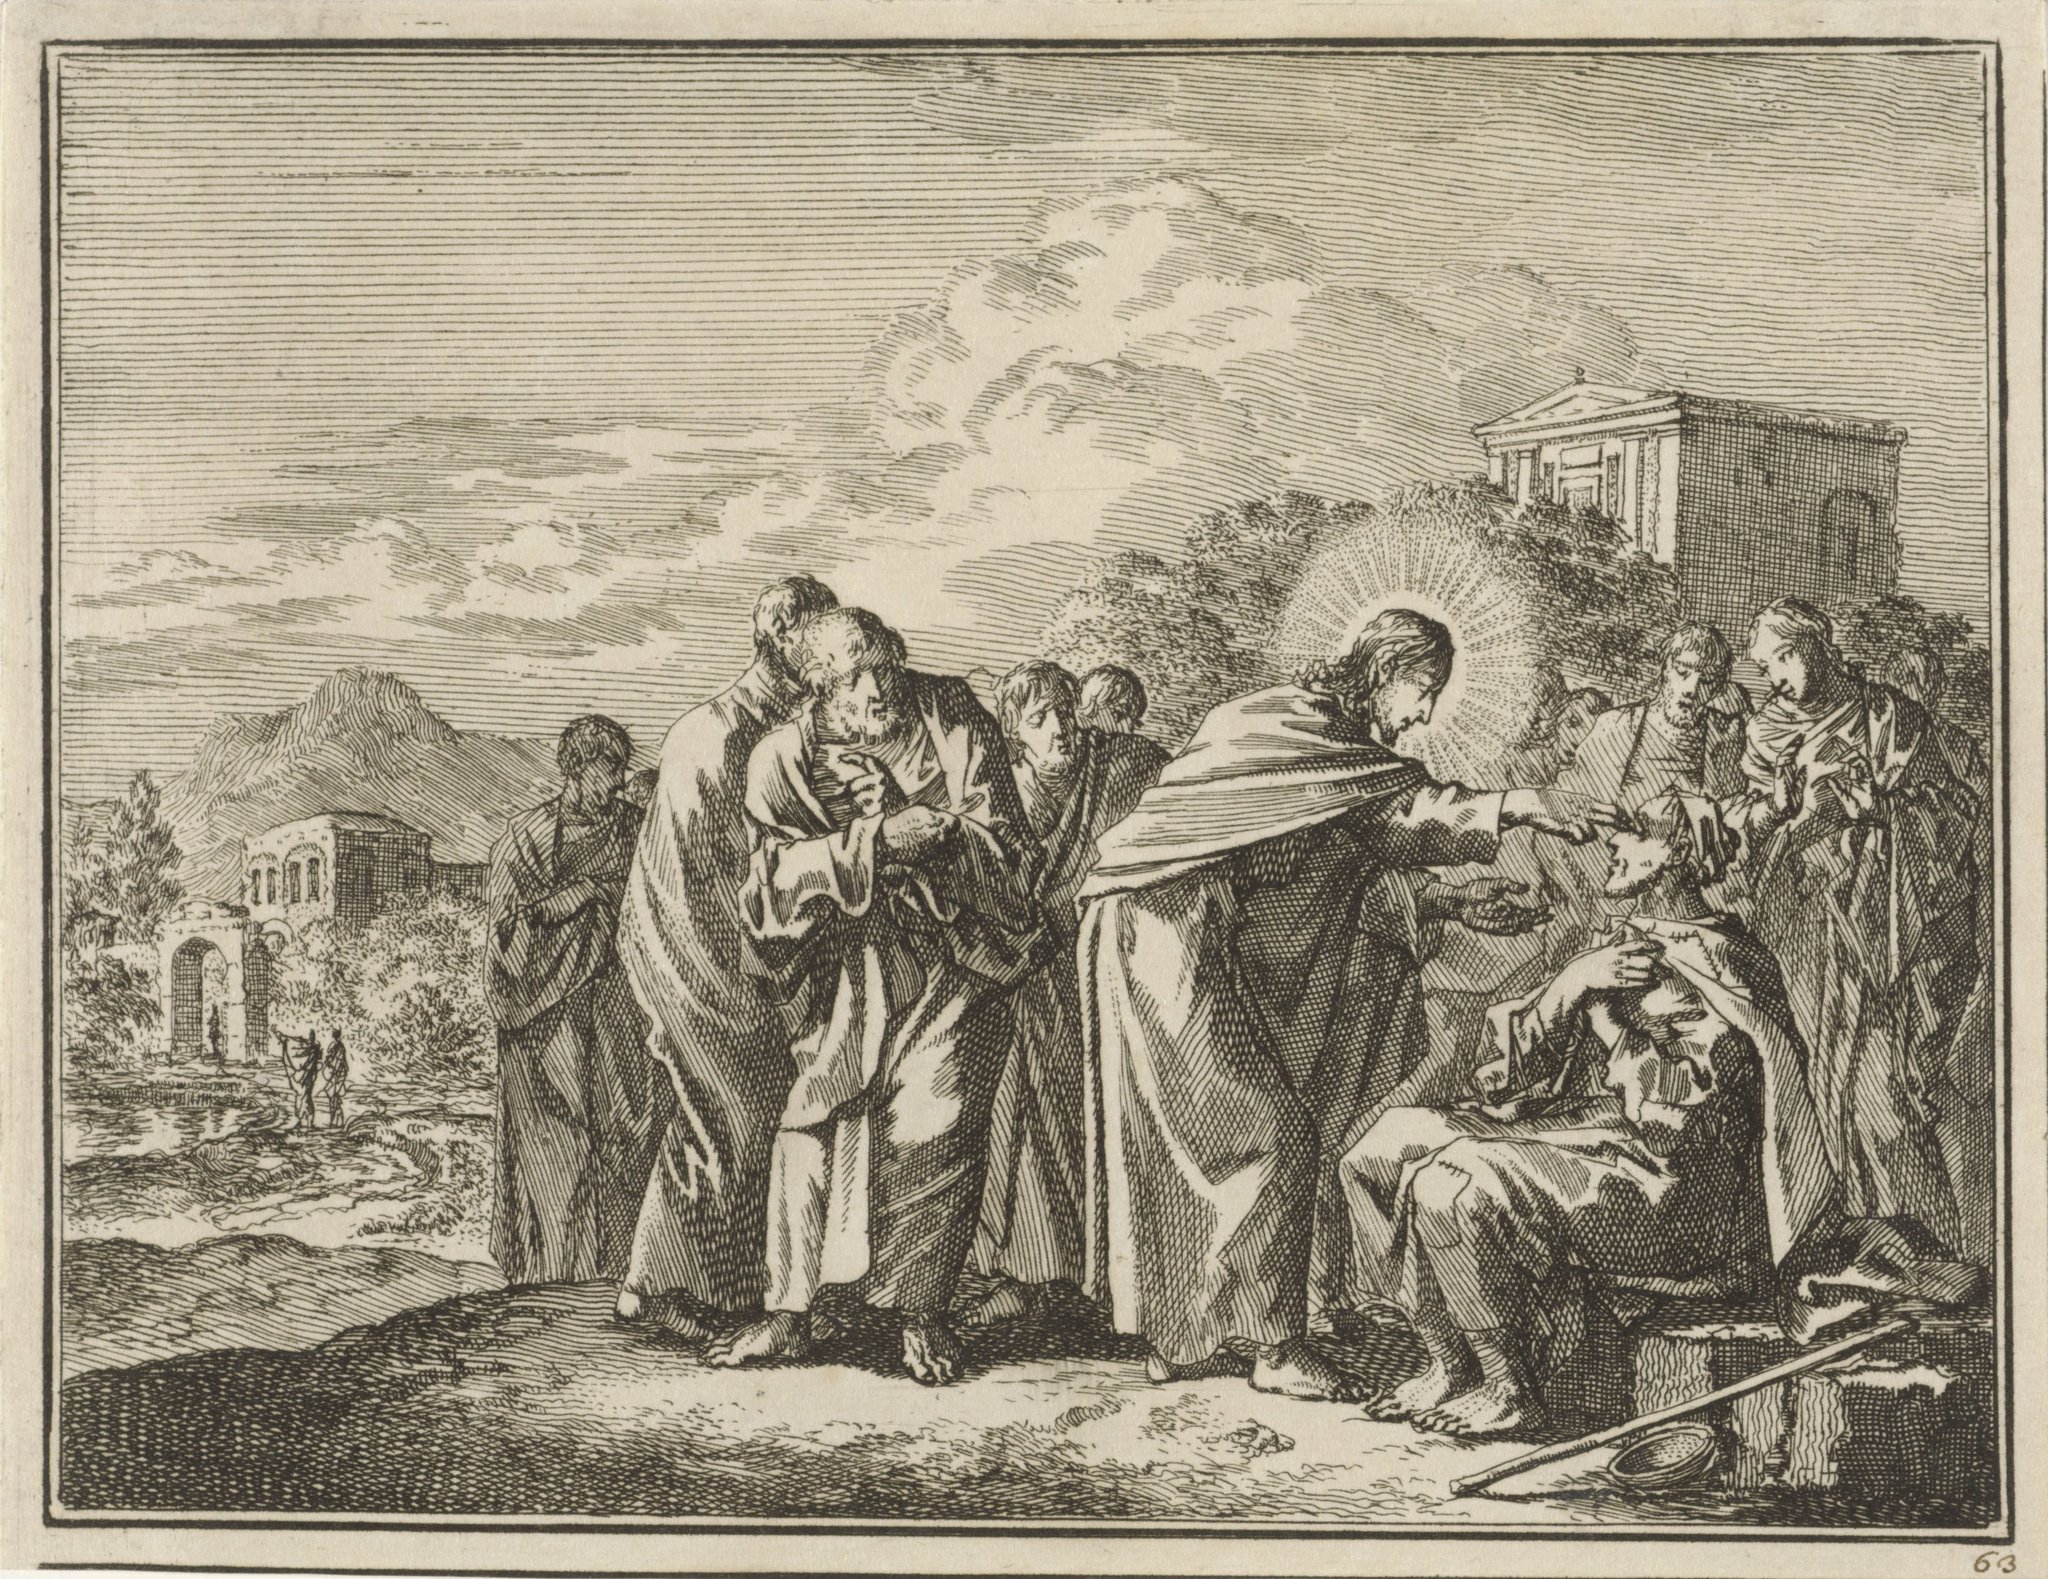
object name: print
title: Christus geneest een man die blind geboren is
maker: jan luyken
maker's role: draughtsman, print maker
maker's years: 1649-1712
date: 1712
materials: paper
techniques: etching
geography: amsterdam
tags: healing of a man born blind: christ touches his eyes with an 'ointment' of dust and spittle (john 9)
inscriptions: number: ‘63’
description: Proefdruk van illustratie uit: Luyken, Jan. De schriftuurlyke geschiedenissen en gelykenissen van het Oude en Nieuwe Verbond, 2 delen. Amsterdam: Wed. Pieter Arentsz II en Cornelis van der Sys, 1712, dl. II.